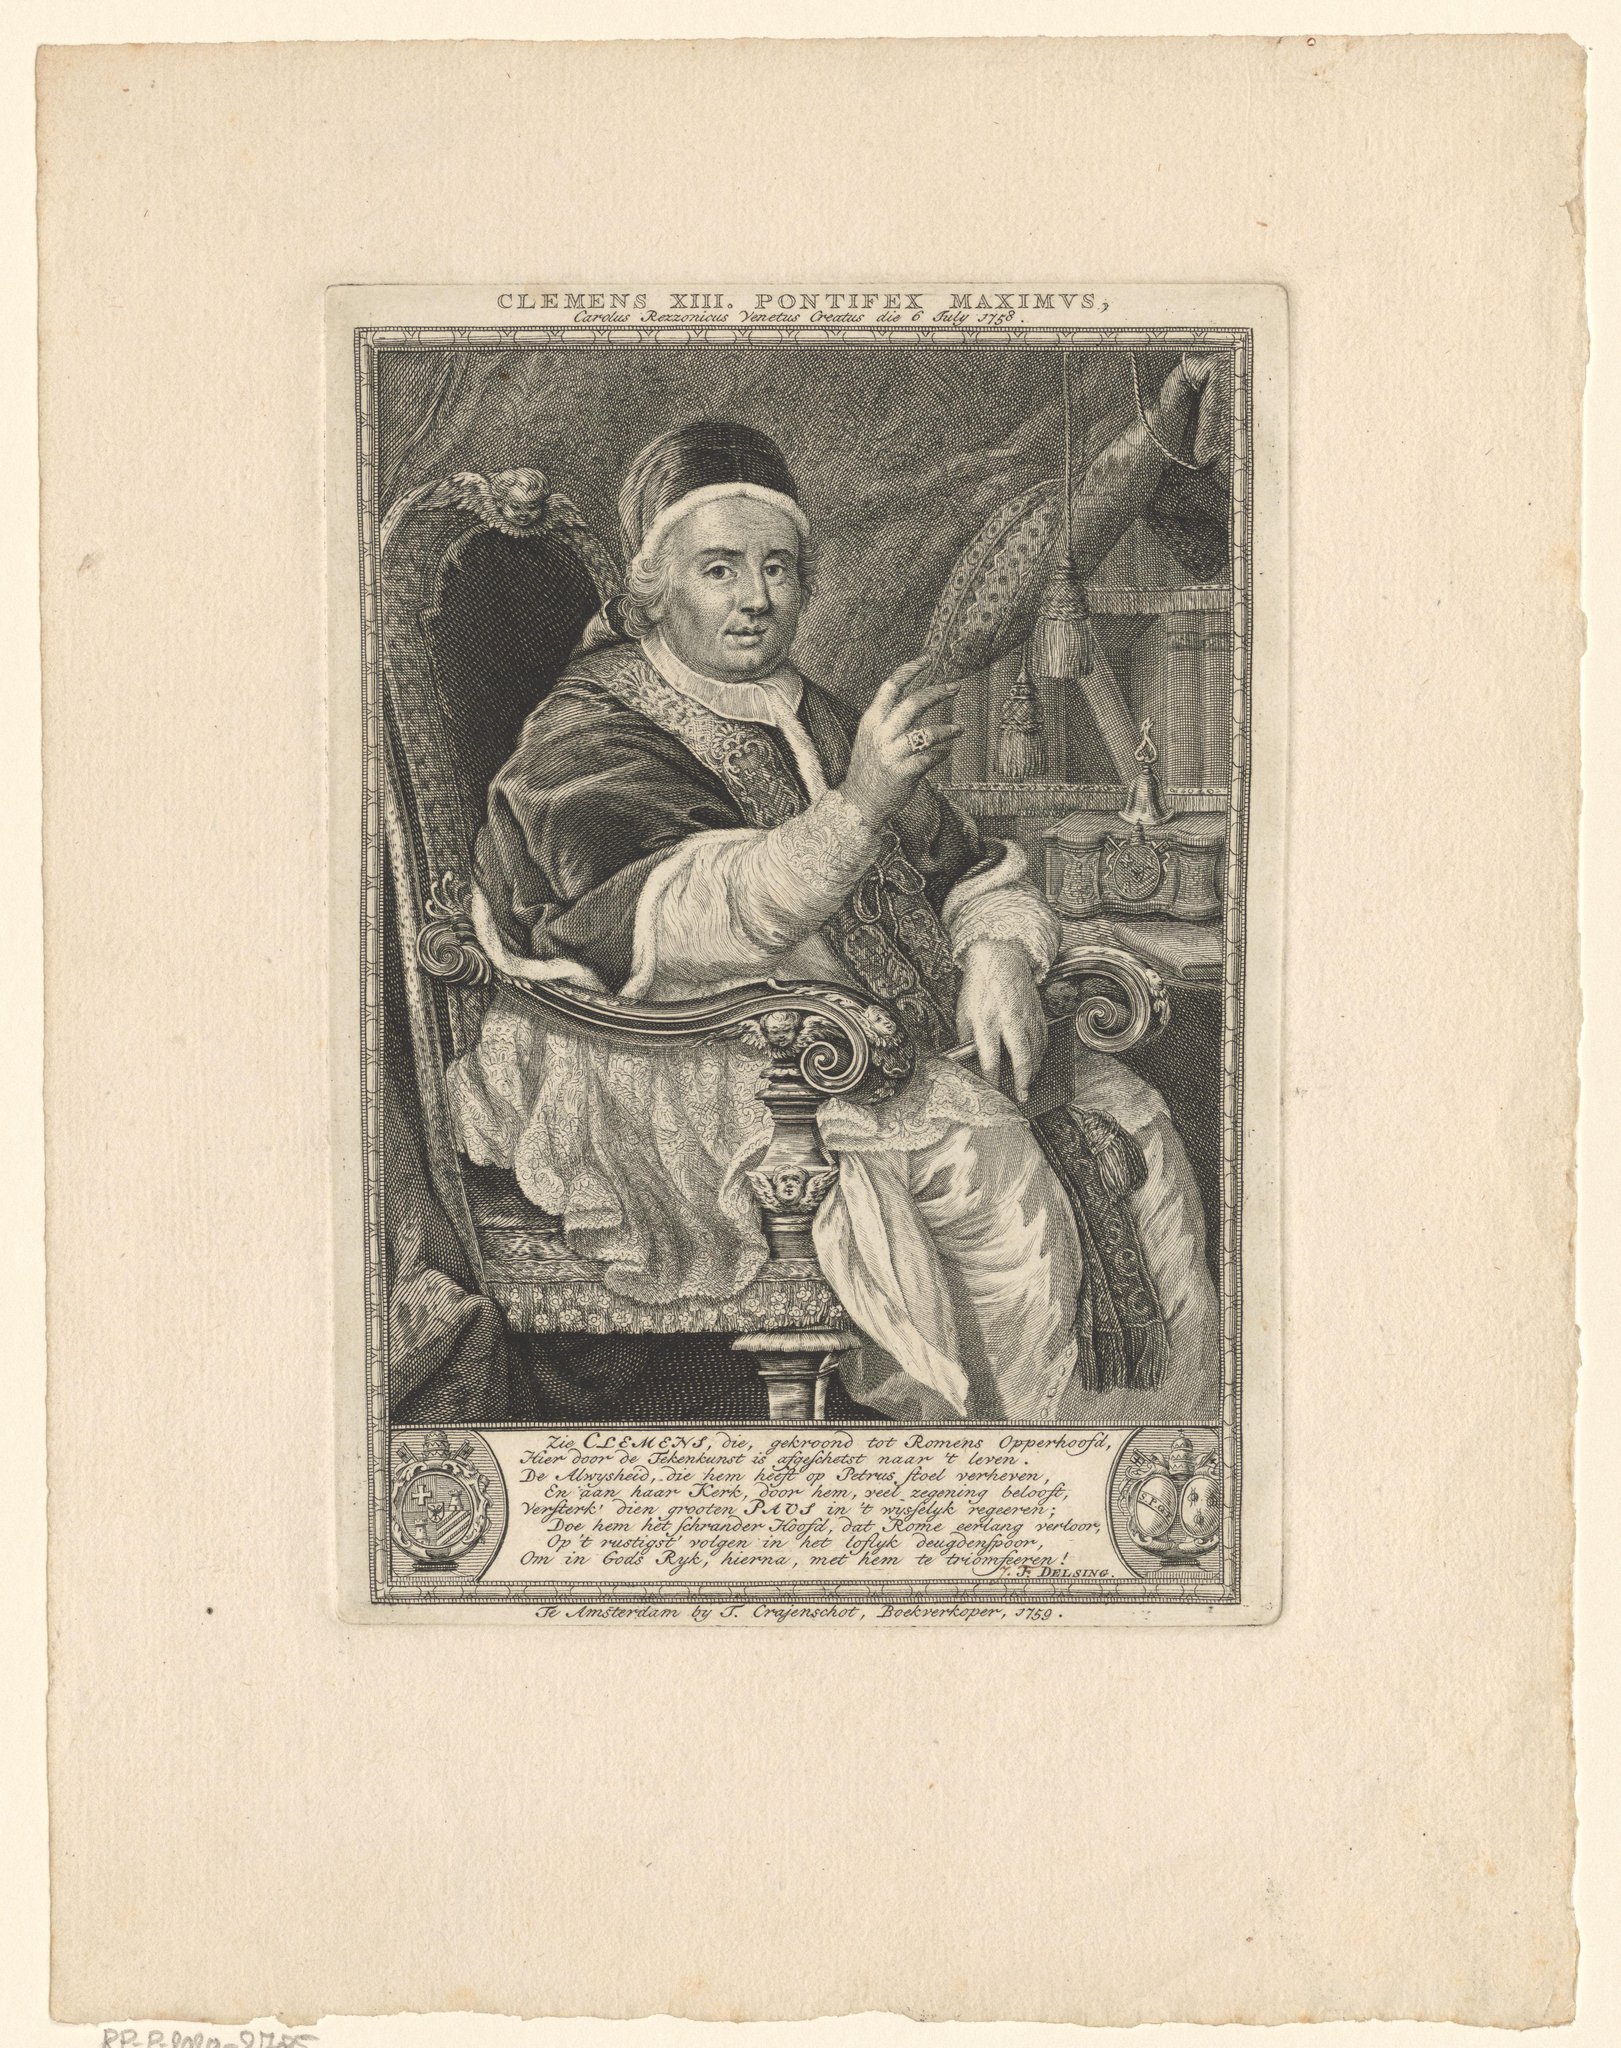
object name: print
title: Portret van paus Clemens XIII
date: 1759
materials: paper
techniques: engraving, etching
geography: amsterdam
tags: clemens xii, historical persons, pope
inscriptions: date